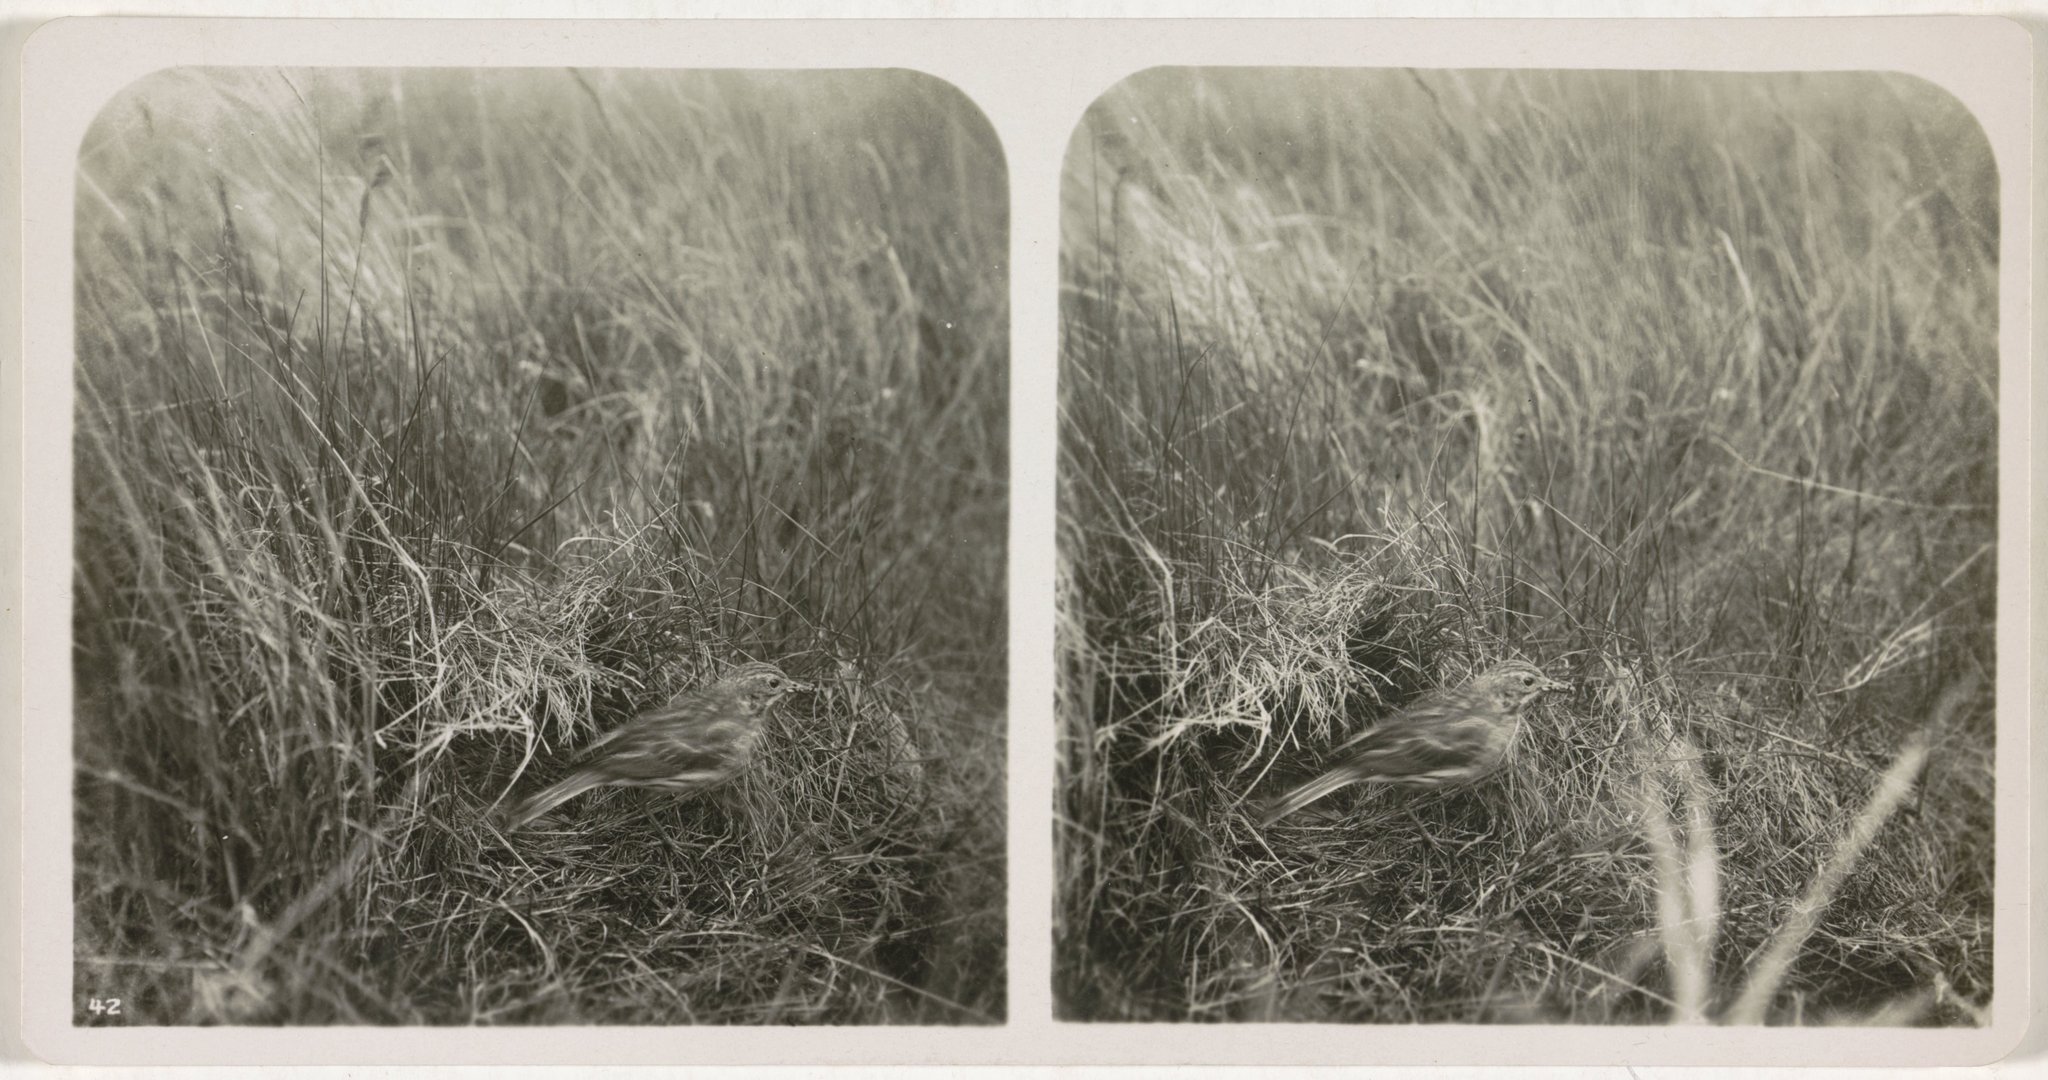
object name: stereograph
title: Graspieper bij nest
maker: adolphe burdet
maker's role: fotograaf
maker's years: 1860-1940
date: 1870-1940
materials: photographic support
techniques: gelatin silver print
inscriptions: label: ‘42 / Anthus pratensis L. / Pipit des prés ou farlouse / Graspieper...’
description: Linksonder op de foto links staat het nummer 42. Uit serie van 25 stereofoto's.